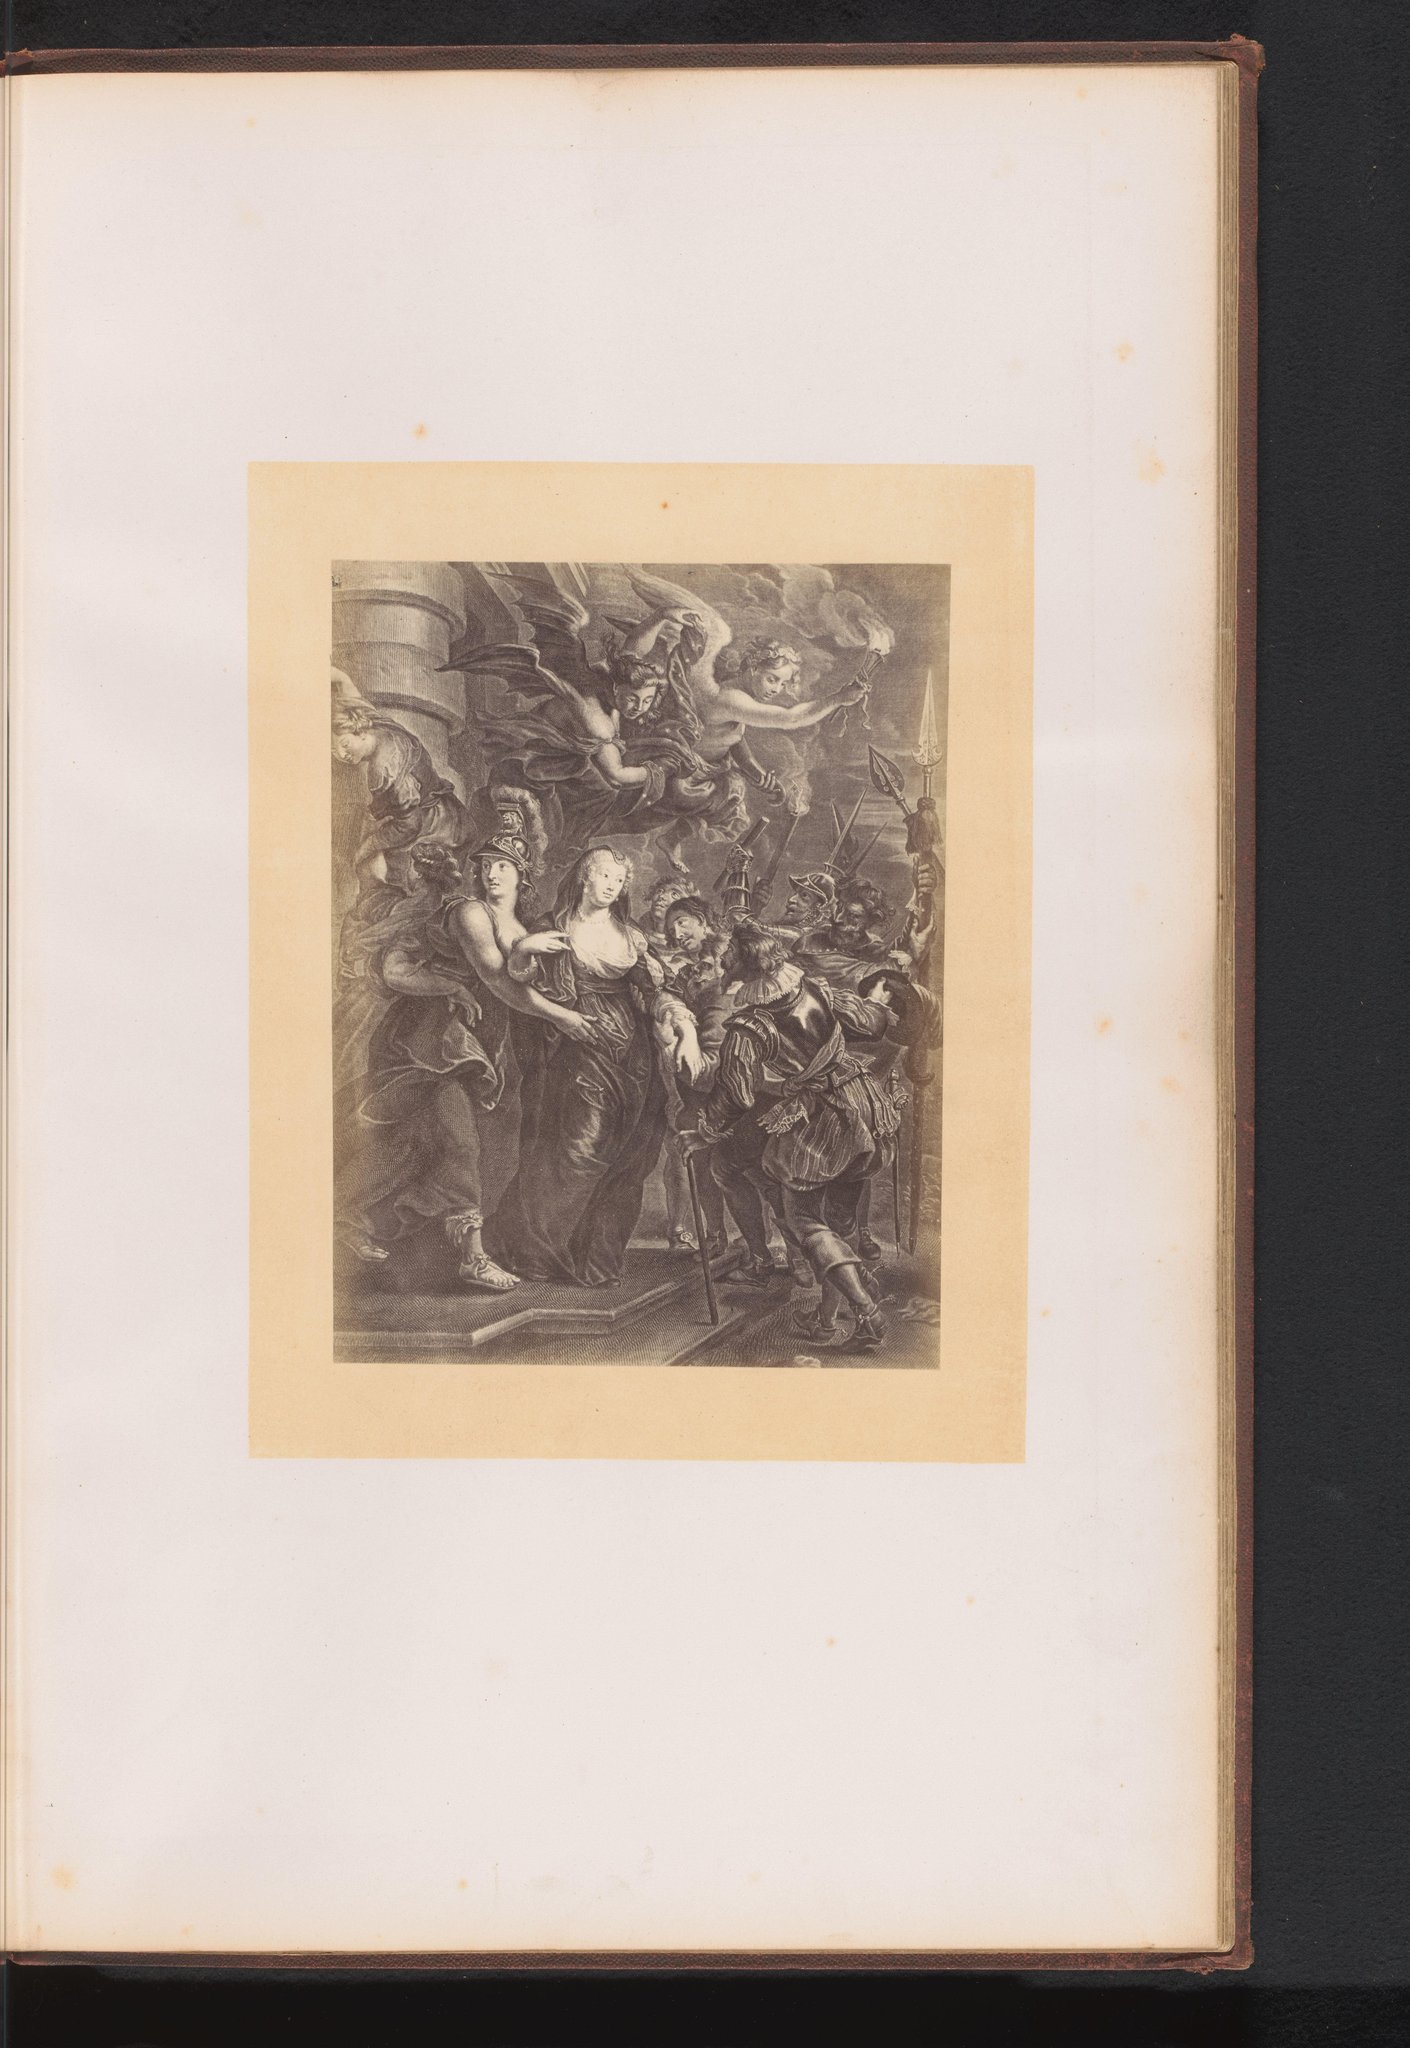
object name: page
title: Fotoreproductie van een gravure van De koningin ontvlucht Blois door Jean-Marc Nattier, naar het schilderij door Peter Paul Rubens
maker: peter paul rubens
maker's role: draughtsman, painter, print maker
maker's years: 1577-1640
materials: photographic support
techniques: albumen print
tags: cologne, maria de' medici, queen, flight, running away; pursuing